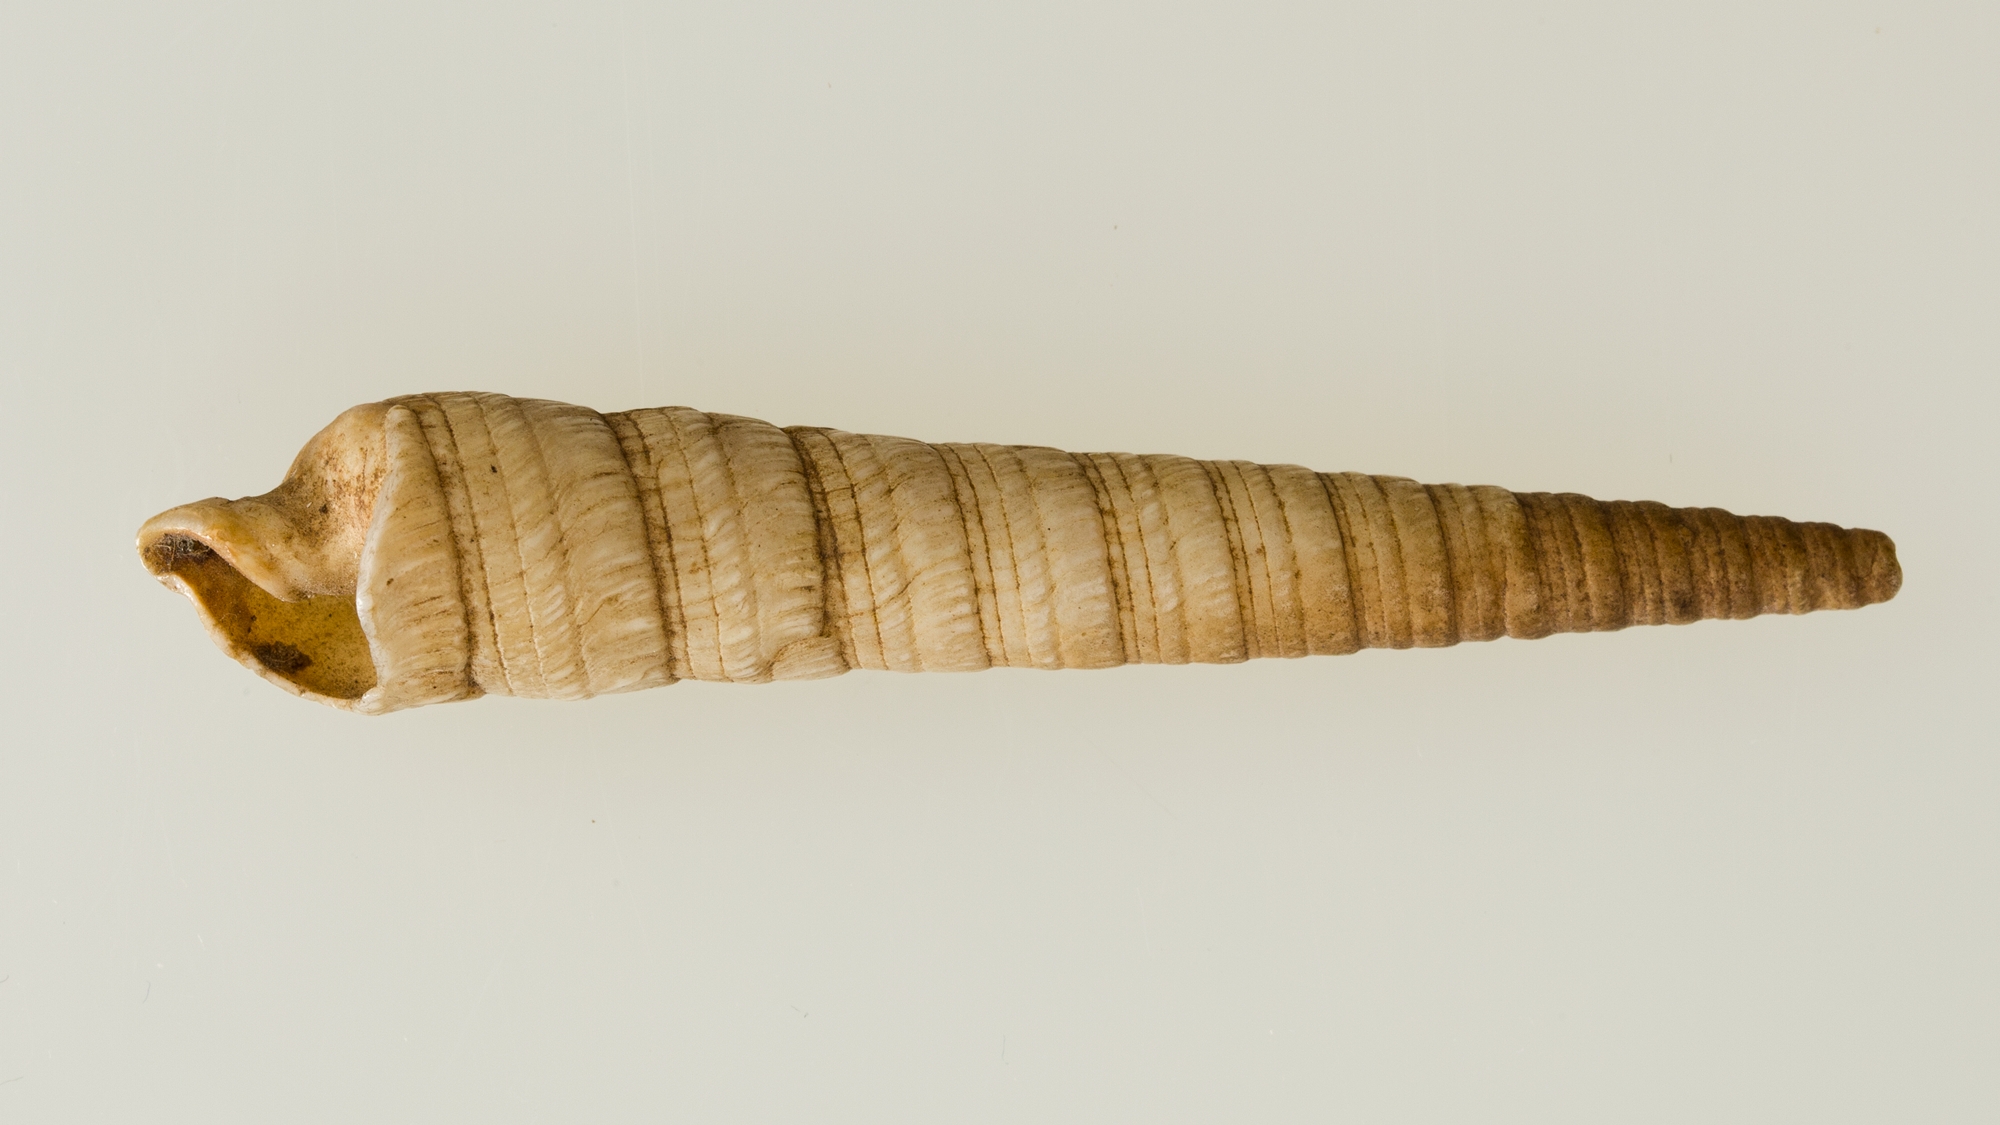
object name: pendant, shell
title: Shell pendant or bead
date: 3850-2960 BCE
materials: shell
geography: egypt